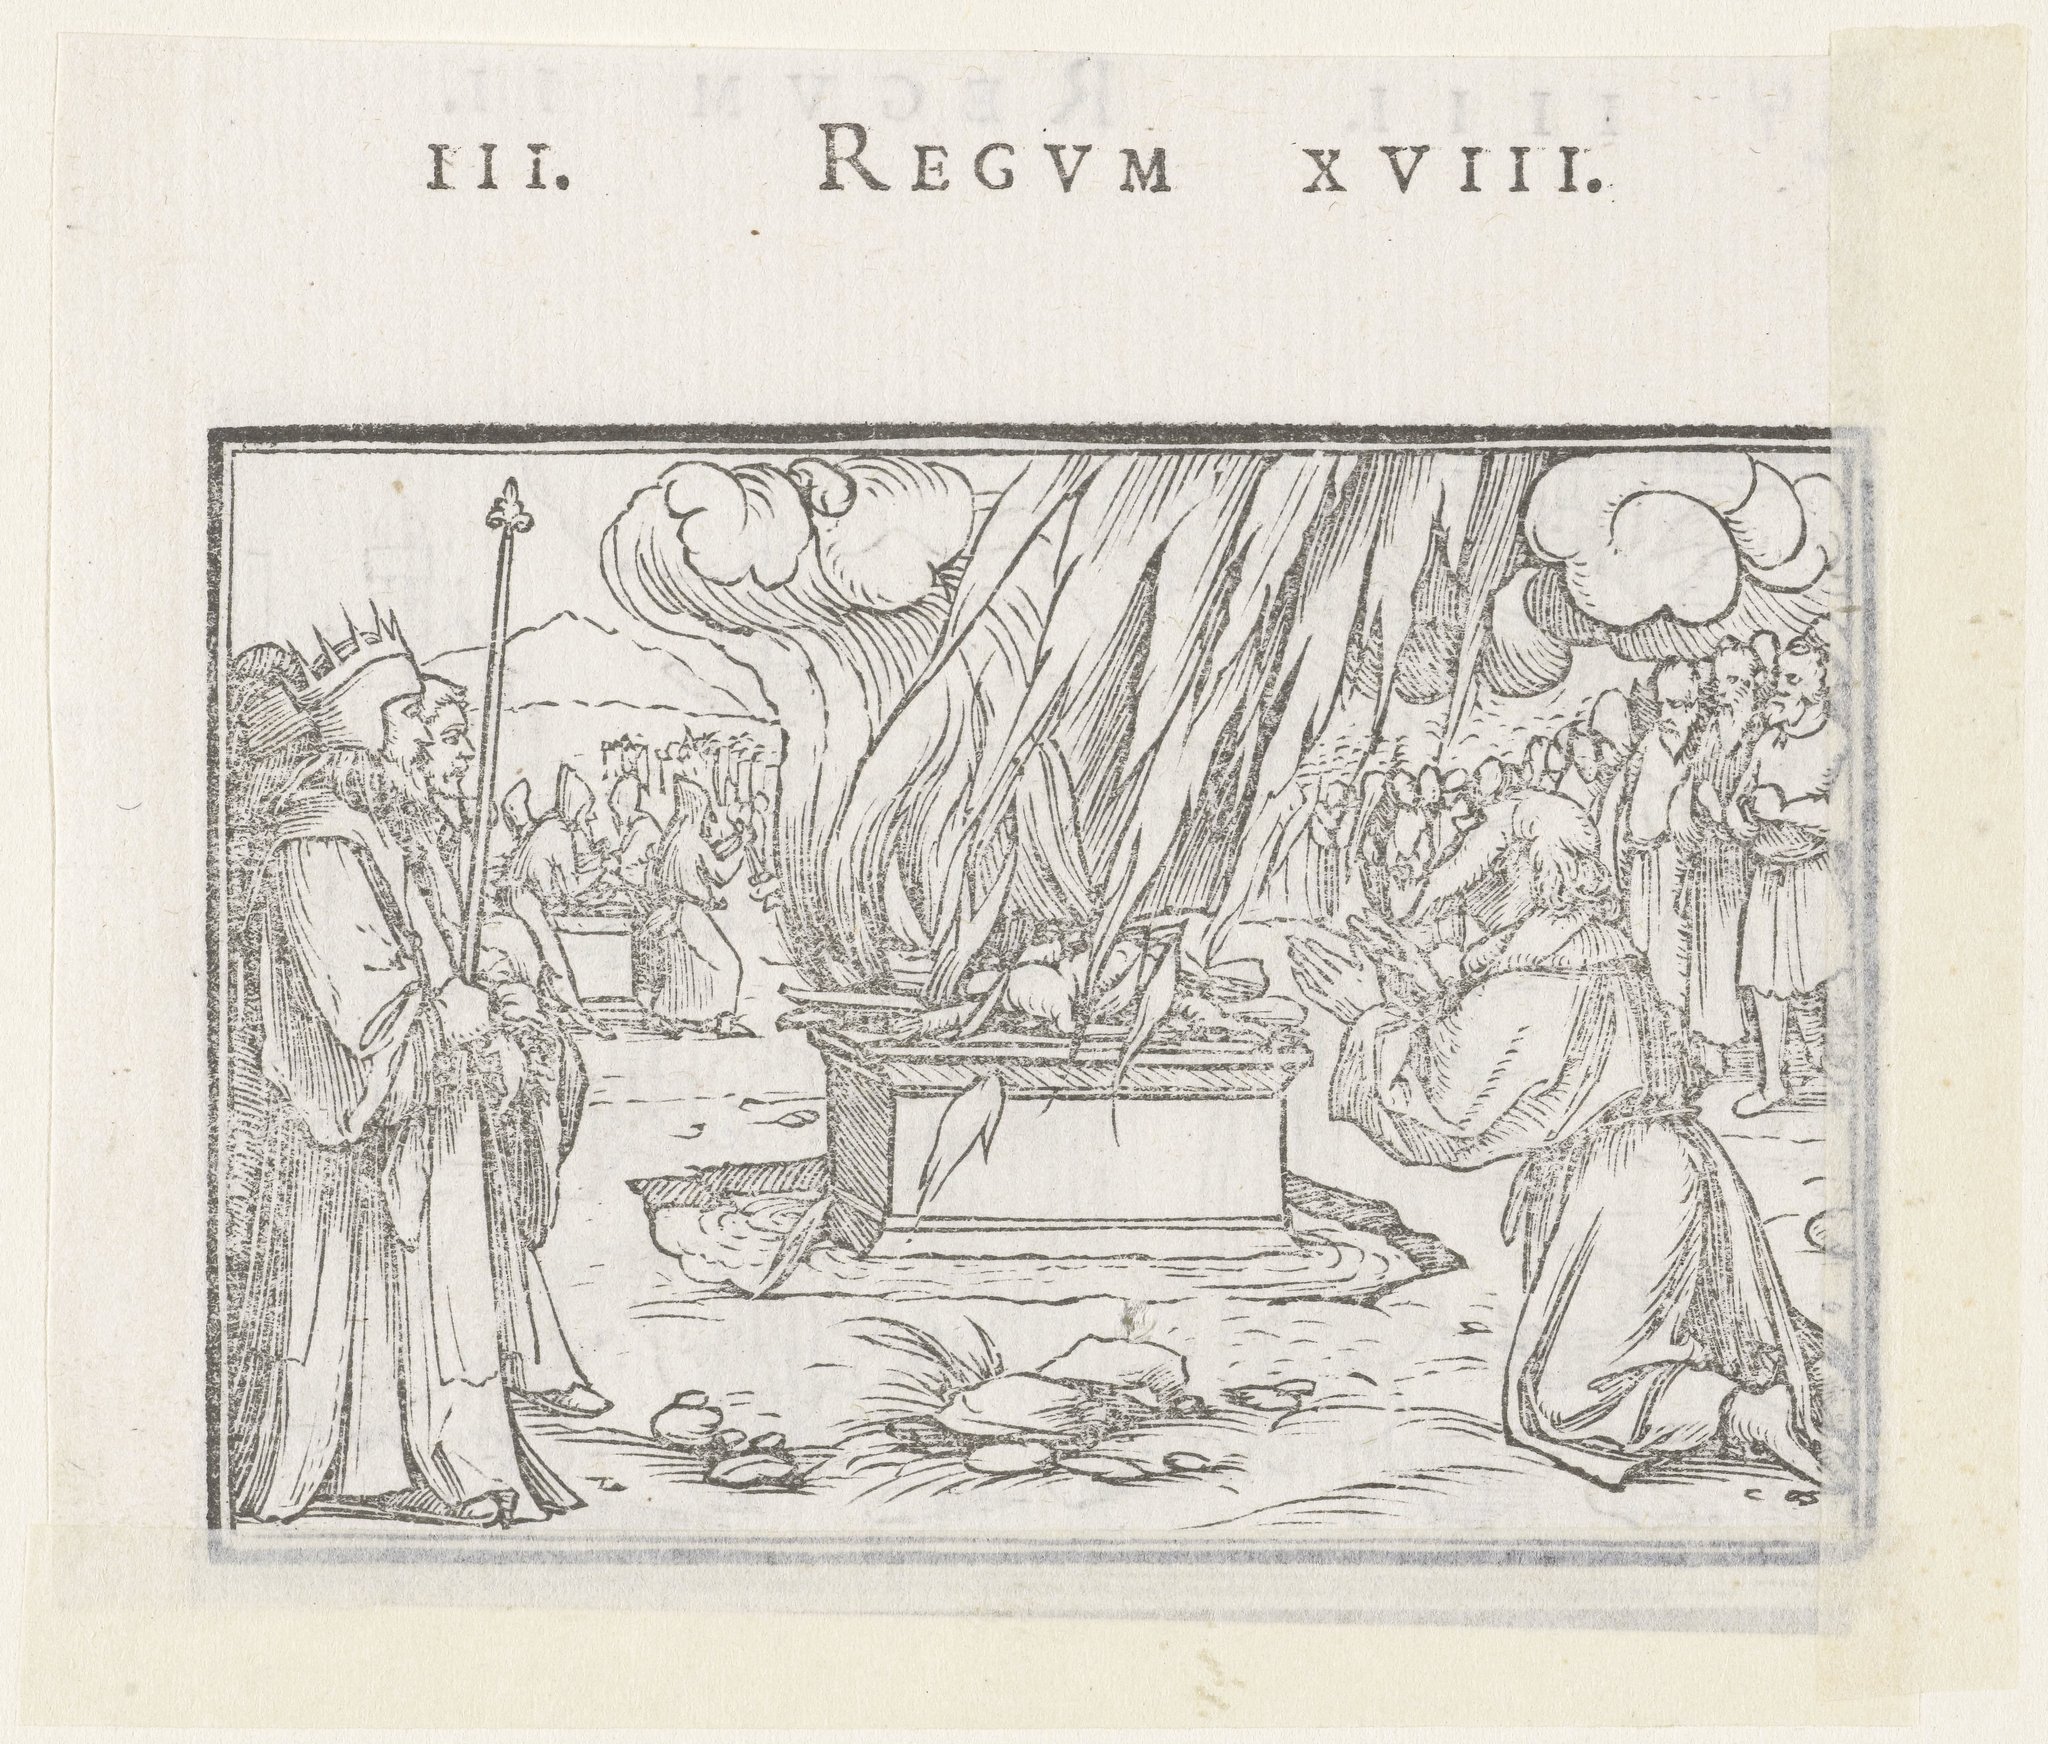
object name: print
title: Offer van Elia door vuur verteerd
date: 1538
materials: paper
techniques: woodcut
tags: ahab is reproved by elijah and asked to gather the priests of baal on mount carmel for a contest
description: Het altaar met het offer van Elia wordt door God met vuur ontstoken als teken van zijn macht. Links staan de Baälpriesters die tevergeefs hebben geprobeerd hun offer te laten branden, rechts knielt Elia terwijl hij God aanroept. In de marge van de afbeelding staat de tekst III Regvm XVIII [2 Koningen 18].